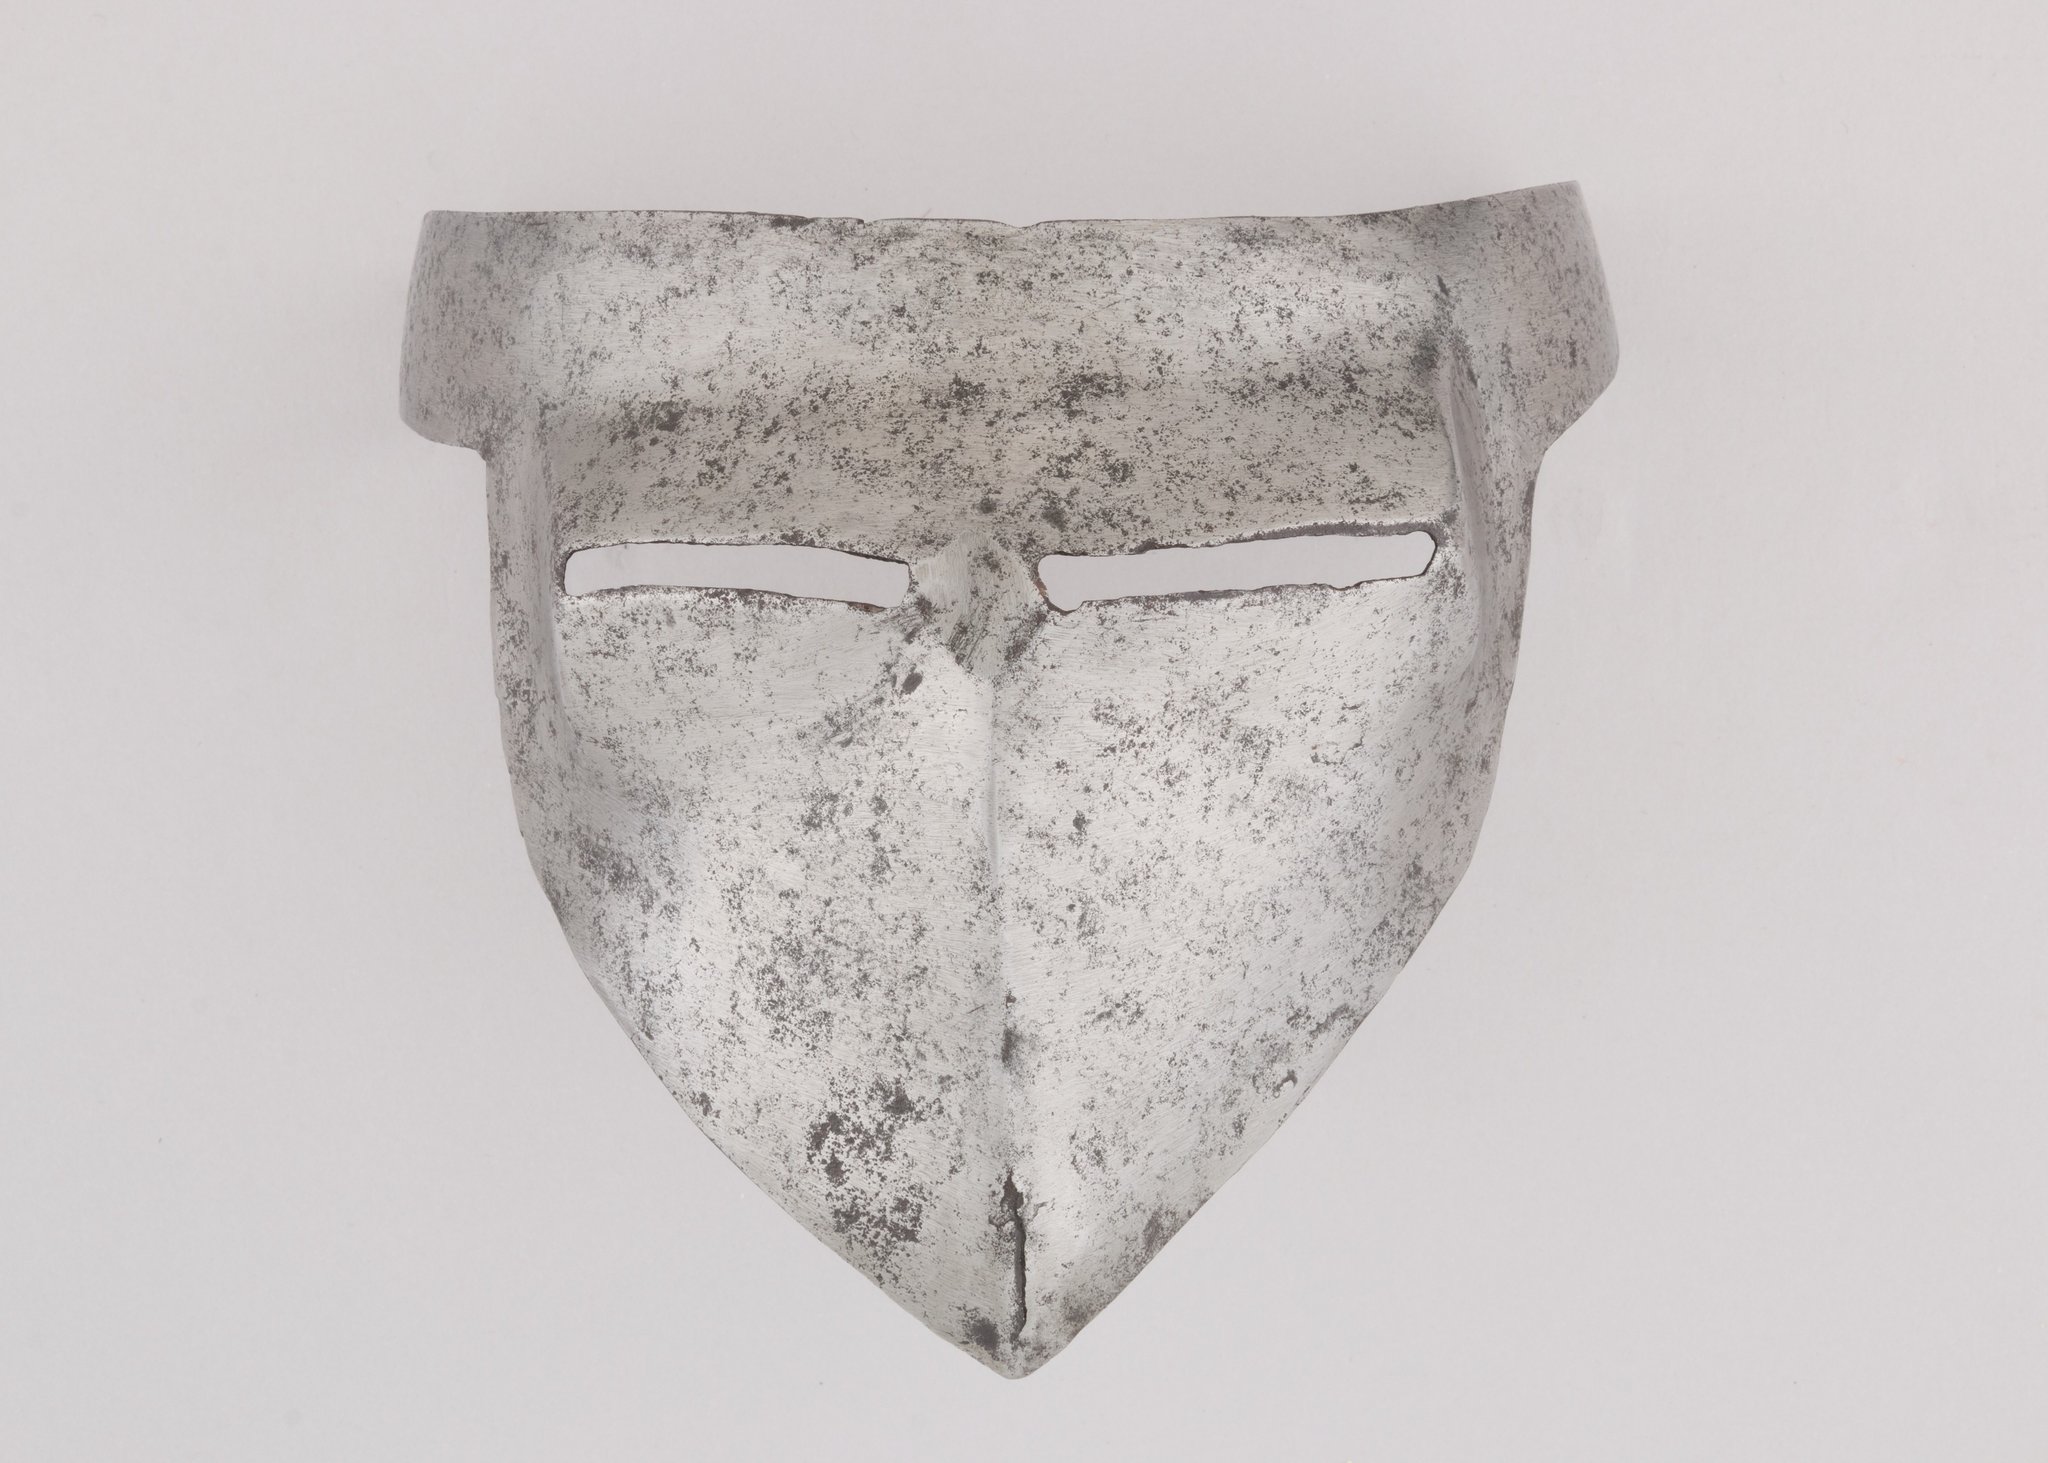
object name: visor for a bascinet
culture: italian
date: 1400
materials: steel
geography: italy